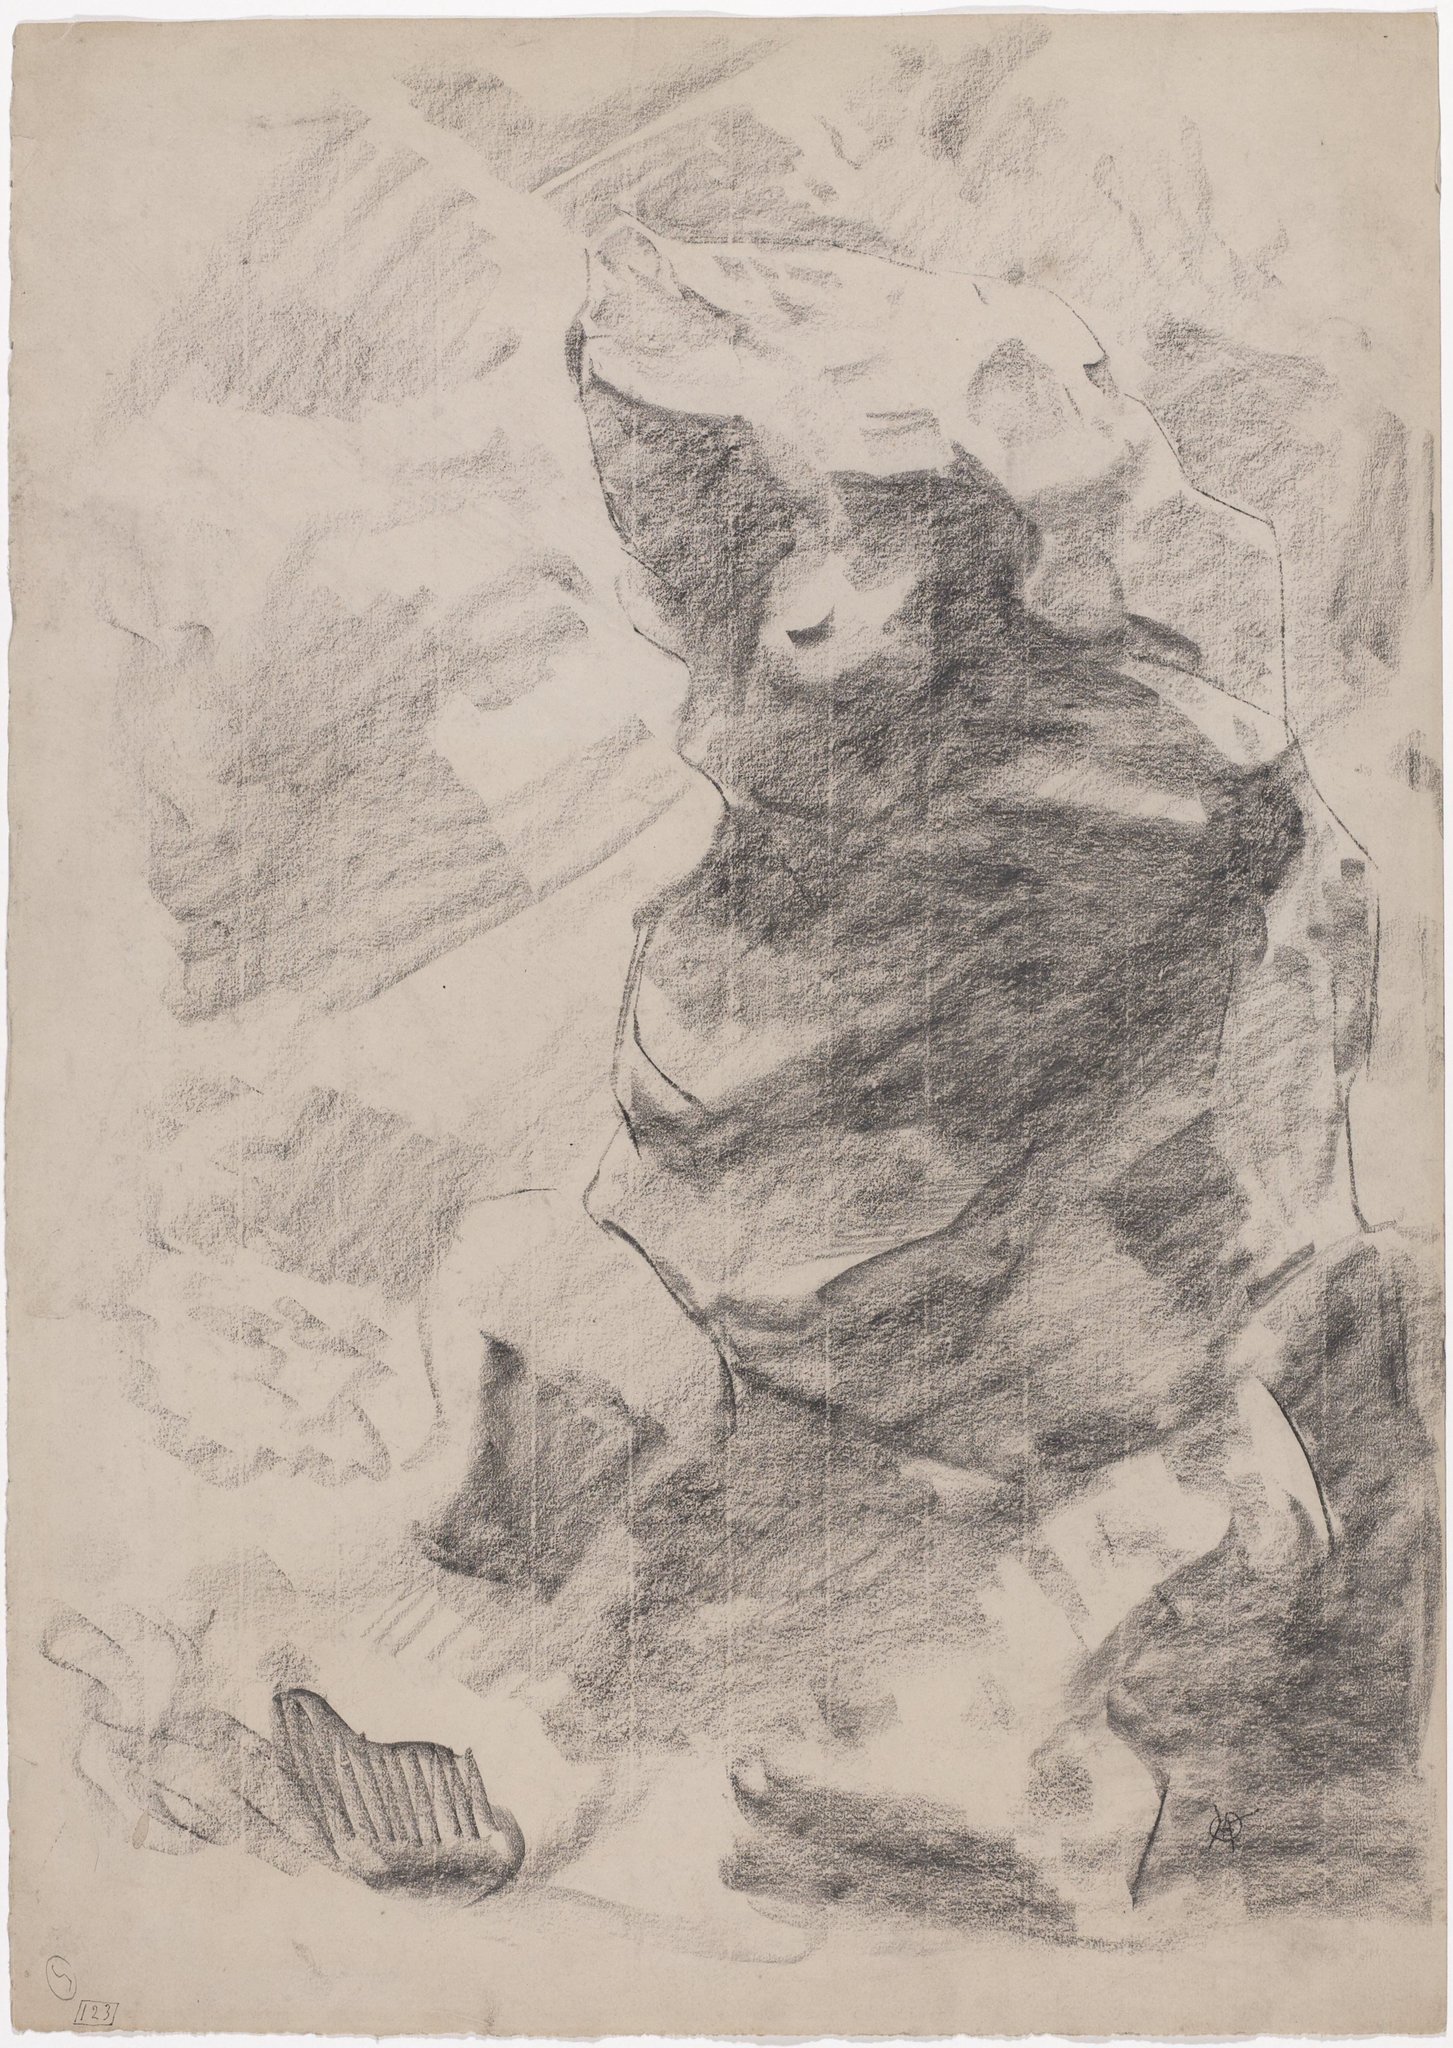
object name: drawing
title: Schets van een aquarium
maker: gerrit willem dijsselhof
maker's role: designer, draughtsman, print maker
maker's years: 1866-1924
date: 1876-1924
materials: chalk, paper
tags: aquarium